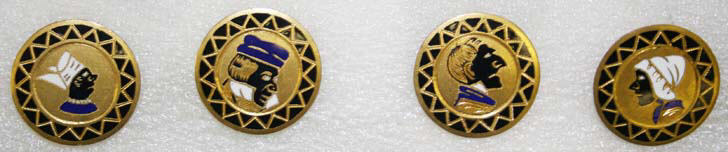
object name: button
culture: french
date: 1880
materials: enamel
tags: men,women